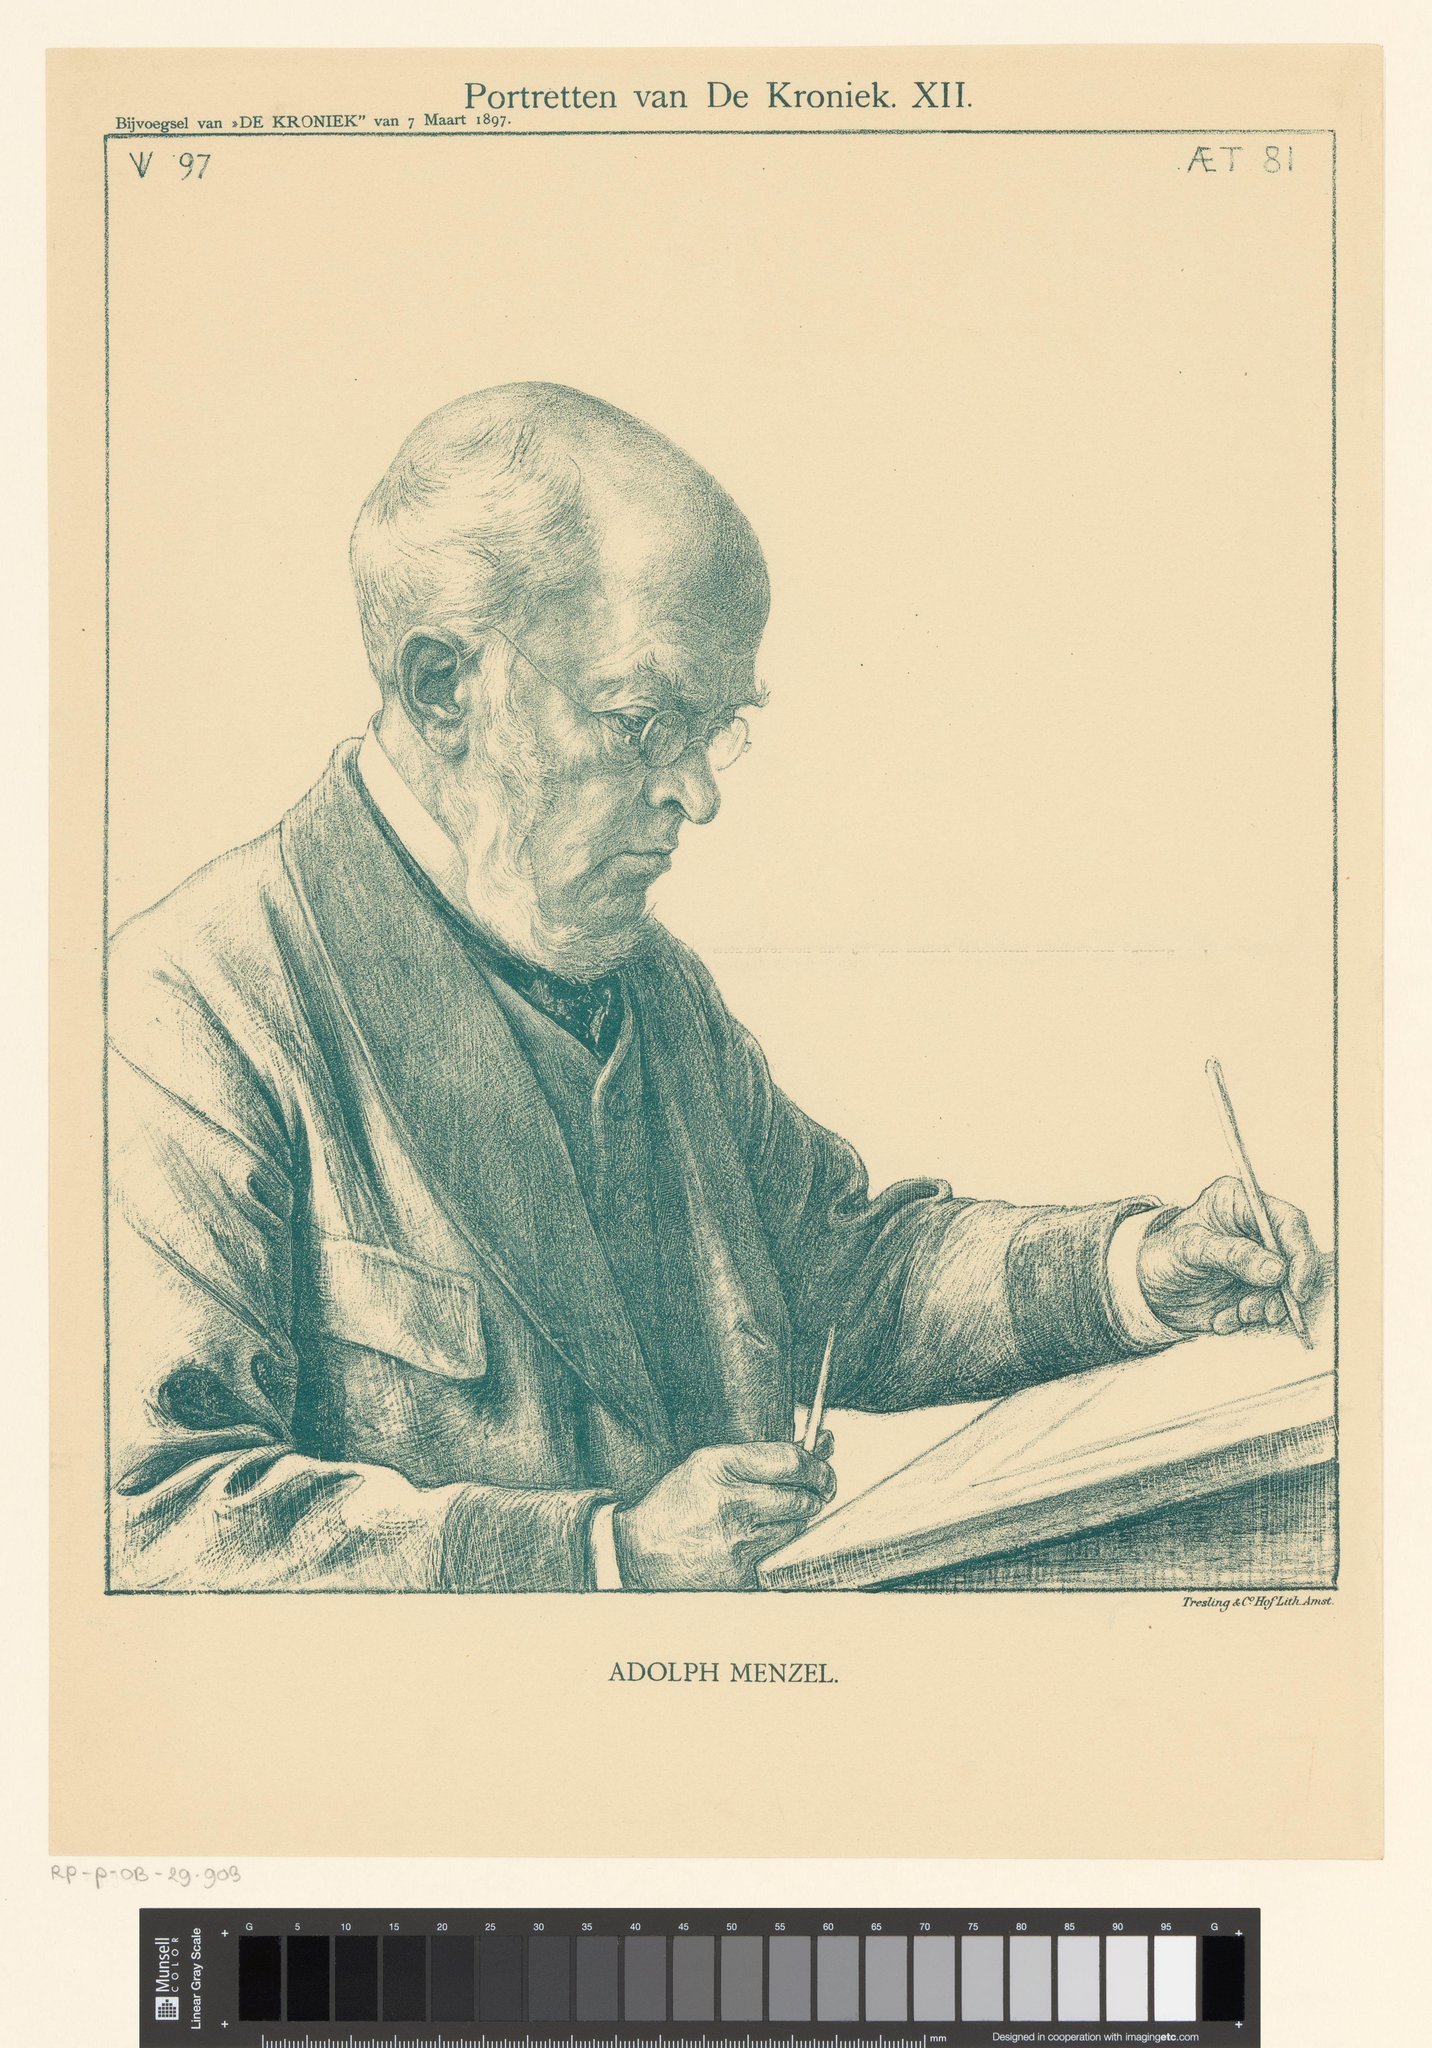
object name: print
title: Portret van Adolph Menzel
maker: jan veth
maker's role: designer, draughtsman, painter, print maker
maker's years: 1864-1925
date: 1897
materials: paper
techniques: lithograph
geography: amsterdam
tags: berlin, painter, print maker, draughtsman, adolph menzel, draughtsman at work, historical persons (+ (full) bust portrait)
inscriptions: collector's mark: Lugt 2228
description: De geportretteerde is bezig met een tekening.